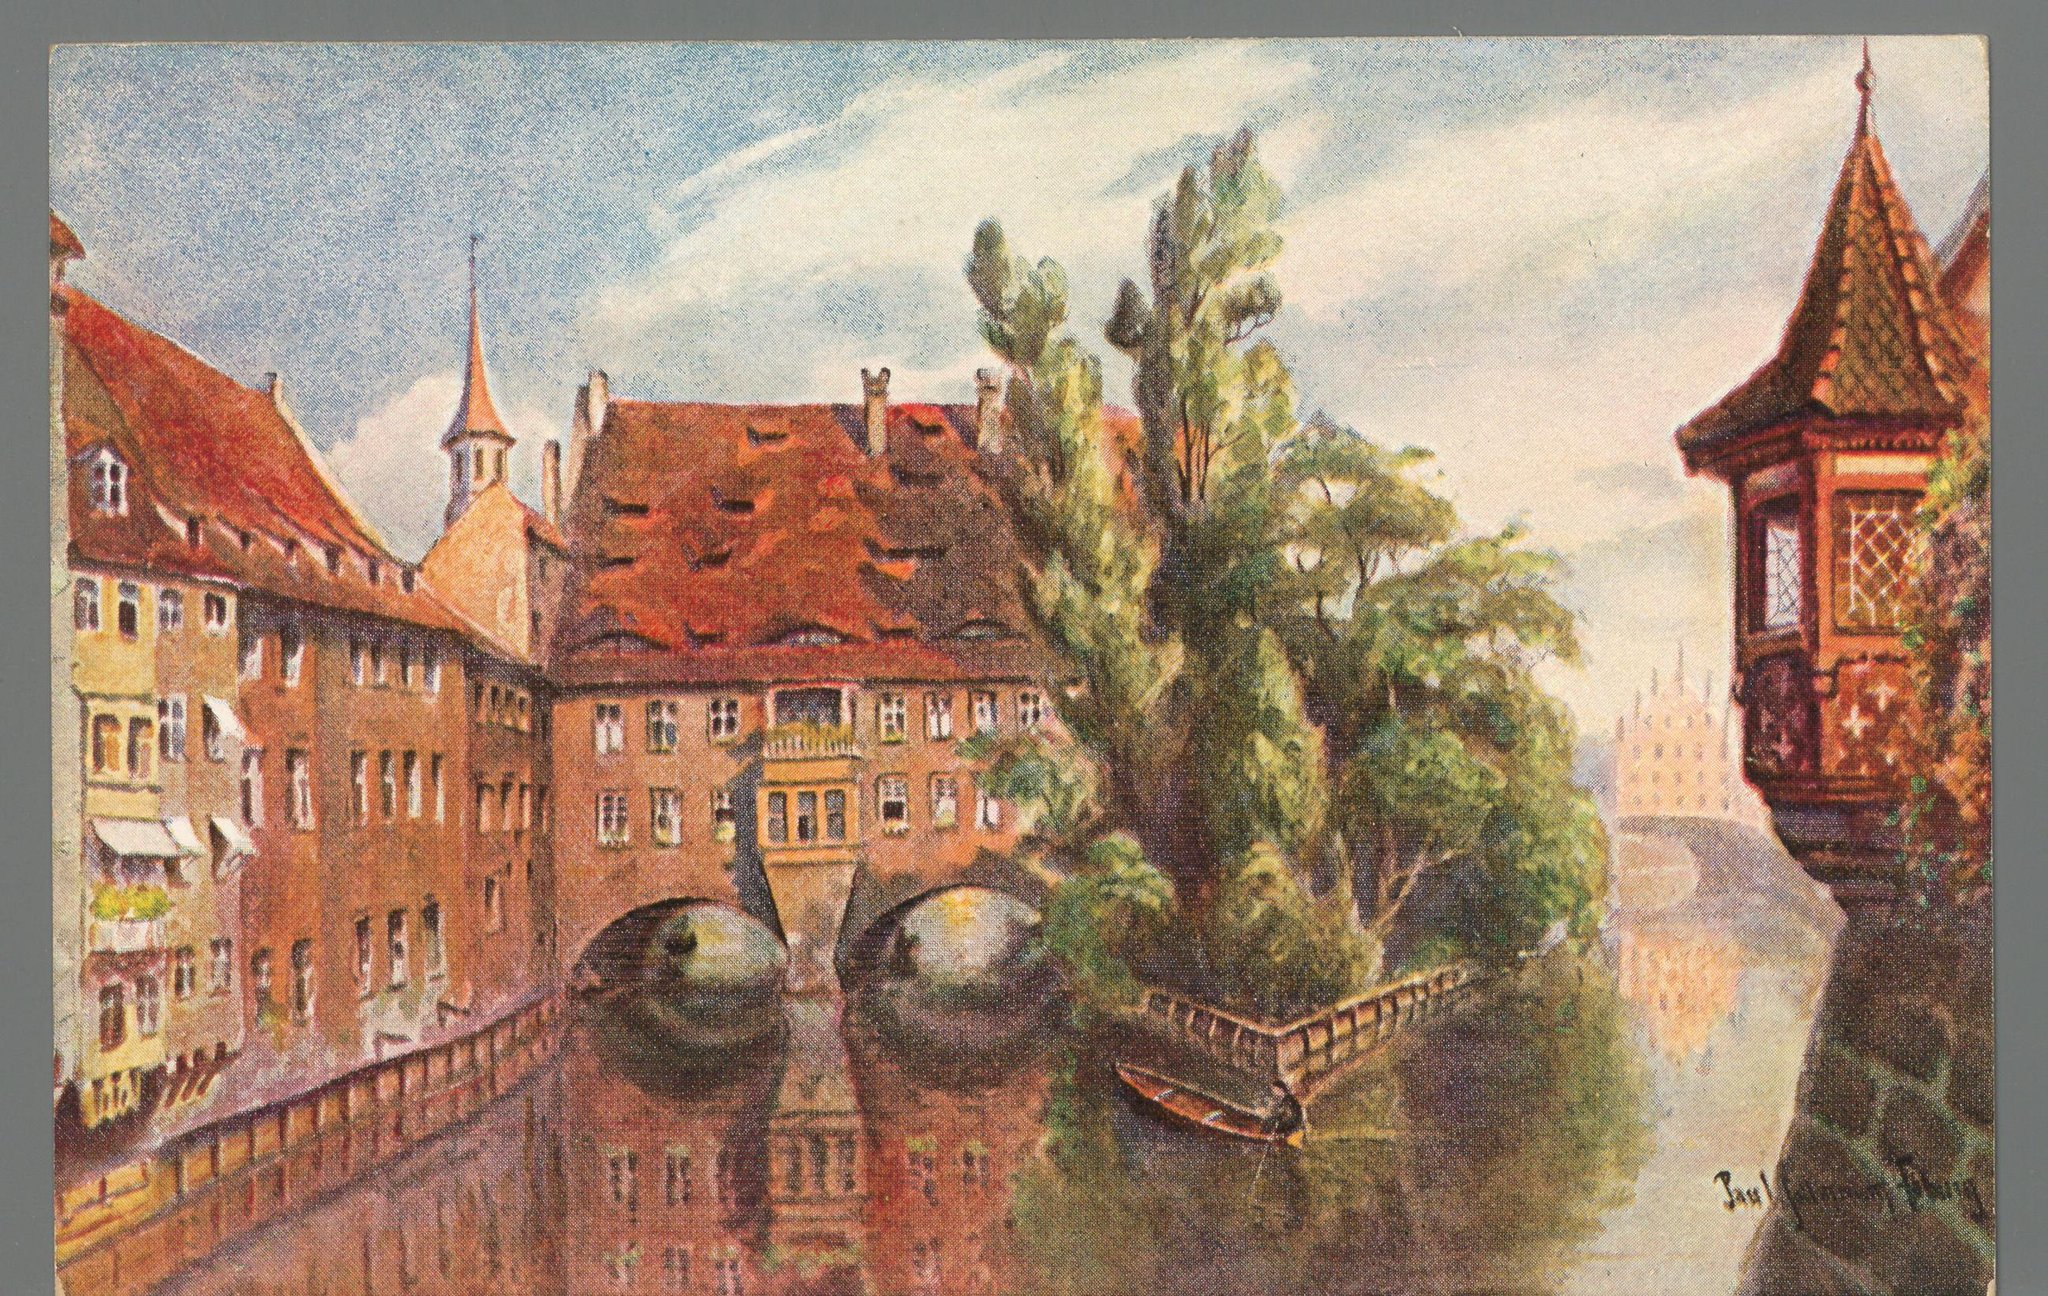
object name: reproduction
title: Nürnberg, Partie an der Museumsbrücke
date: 1905-1909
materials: cardboard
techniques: writing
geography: nuremberg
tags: canals, waters (in city), permanent exhibition, museum, bridge in city across river, canal, etc.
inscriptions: inscription: ‘Paul [...]mann [...]burg’